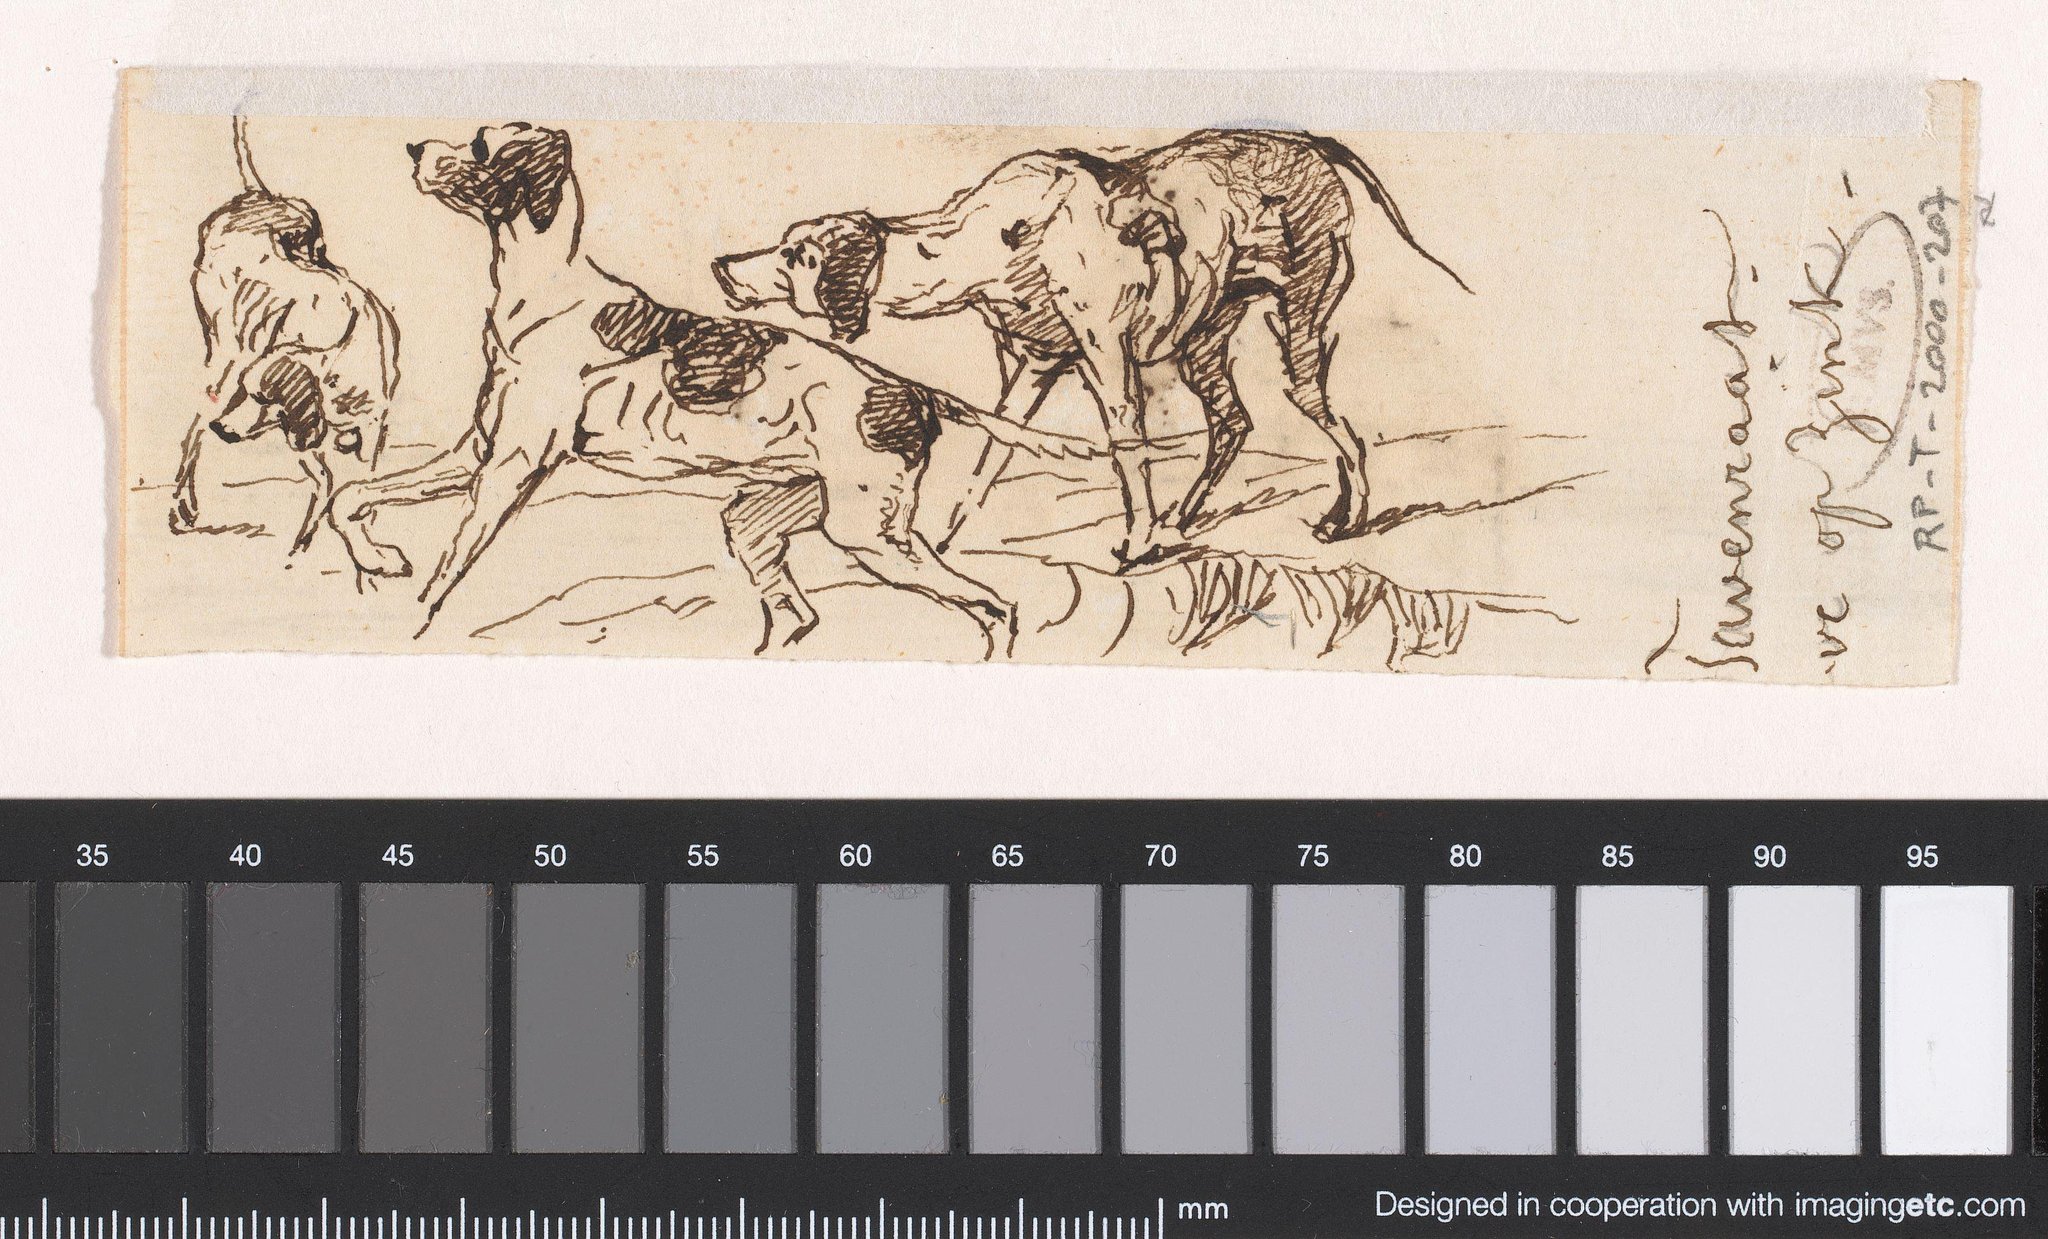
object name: drawing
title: Jachthonden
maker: johannes tavenraat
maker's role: draughtsman, painter, print maker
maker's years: 1809-1881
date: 1840-1880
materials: ink, paper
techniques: pen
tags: hunting dogs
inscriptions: collector's mark: Lugt 2228, signature: ‘Tavenraat / ... op zink’